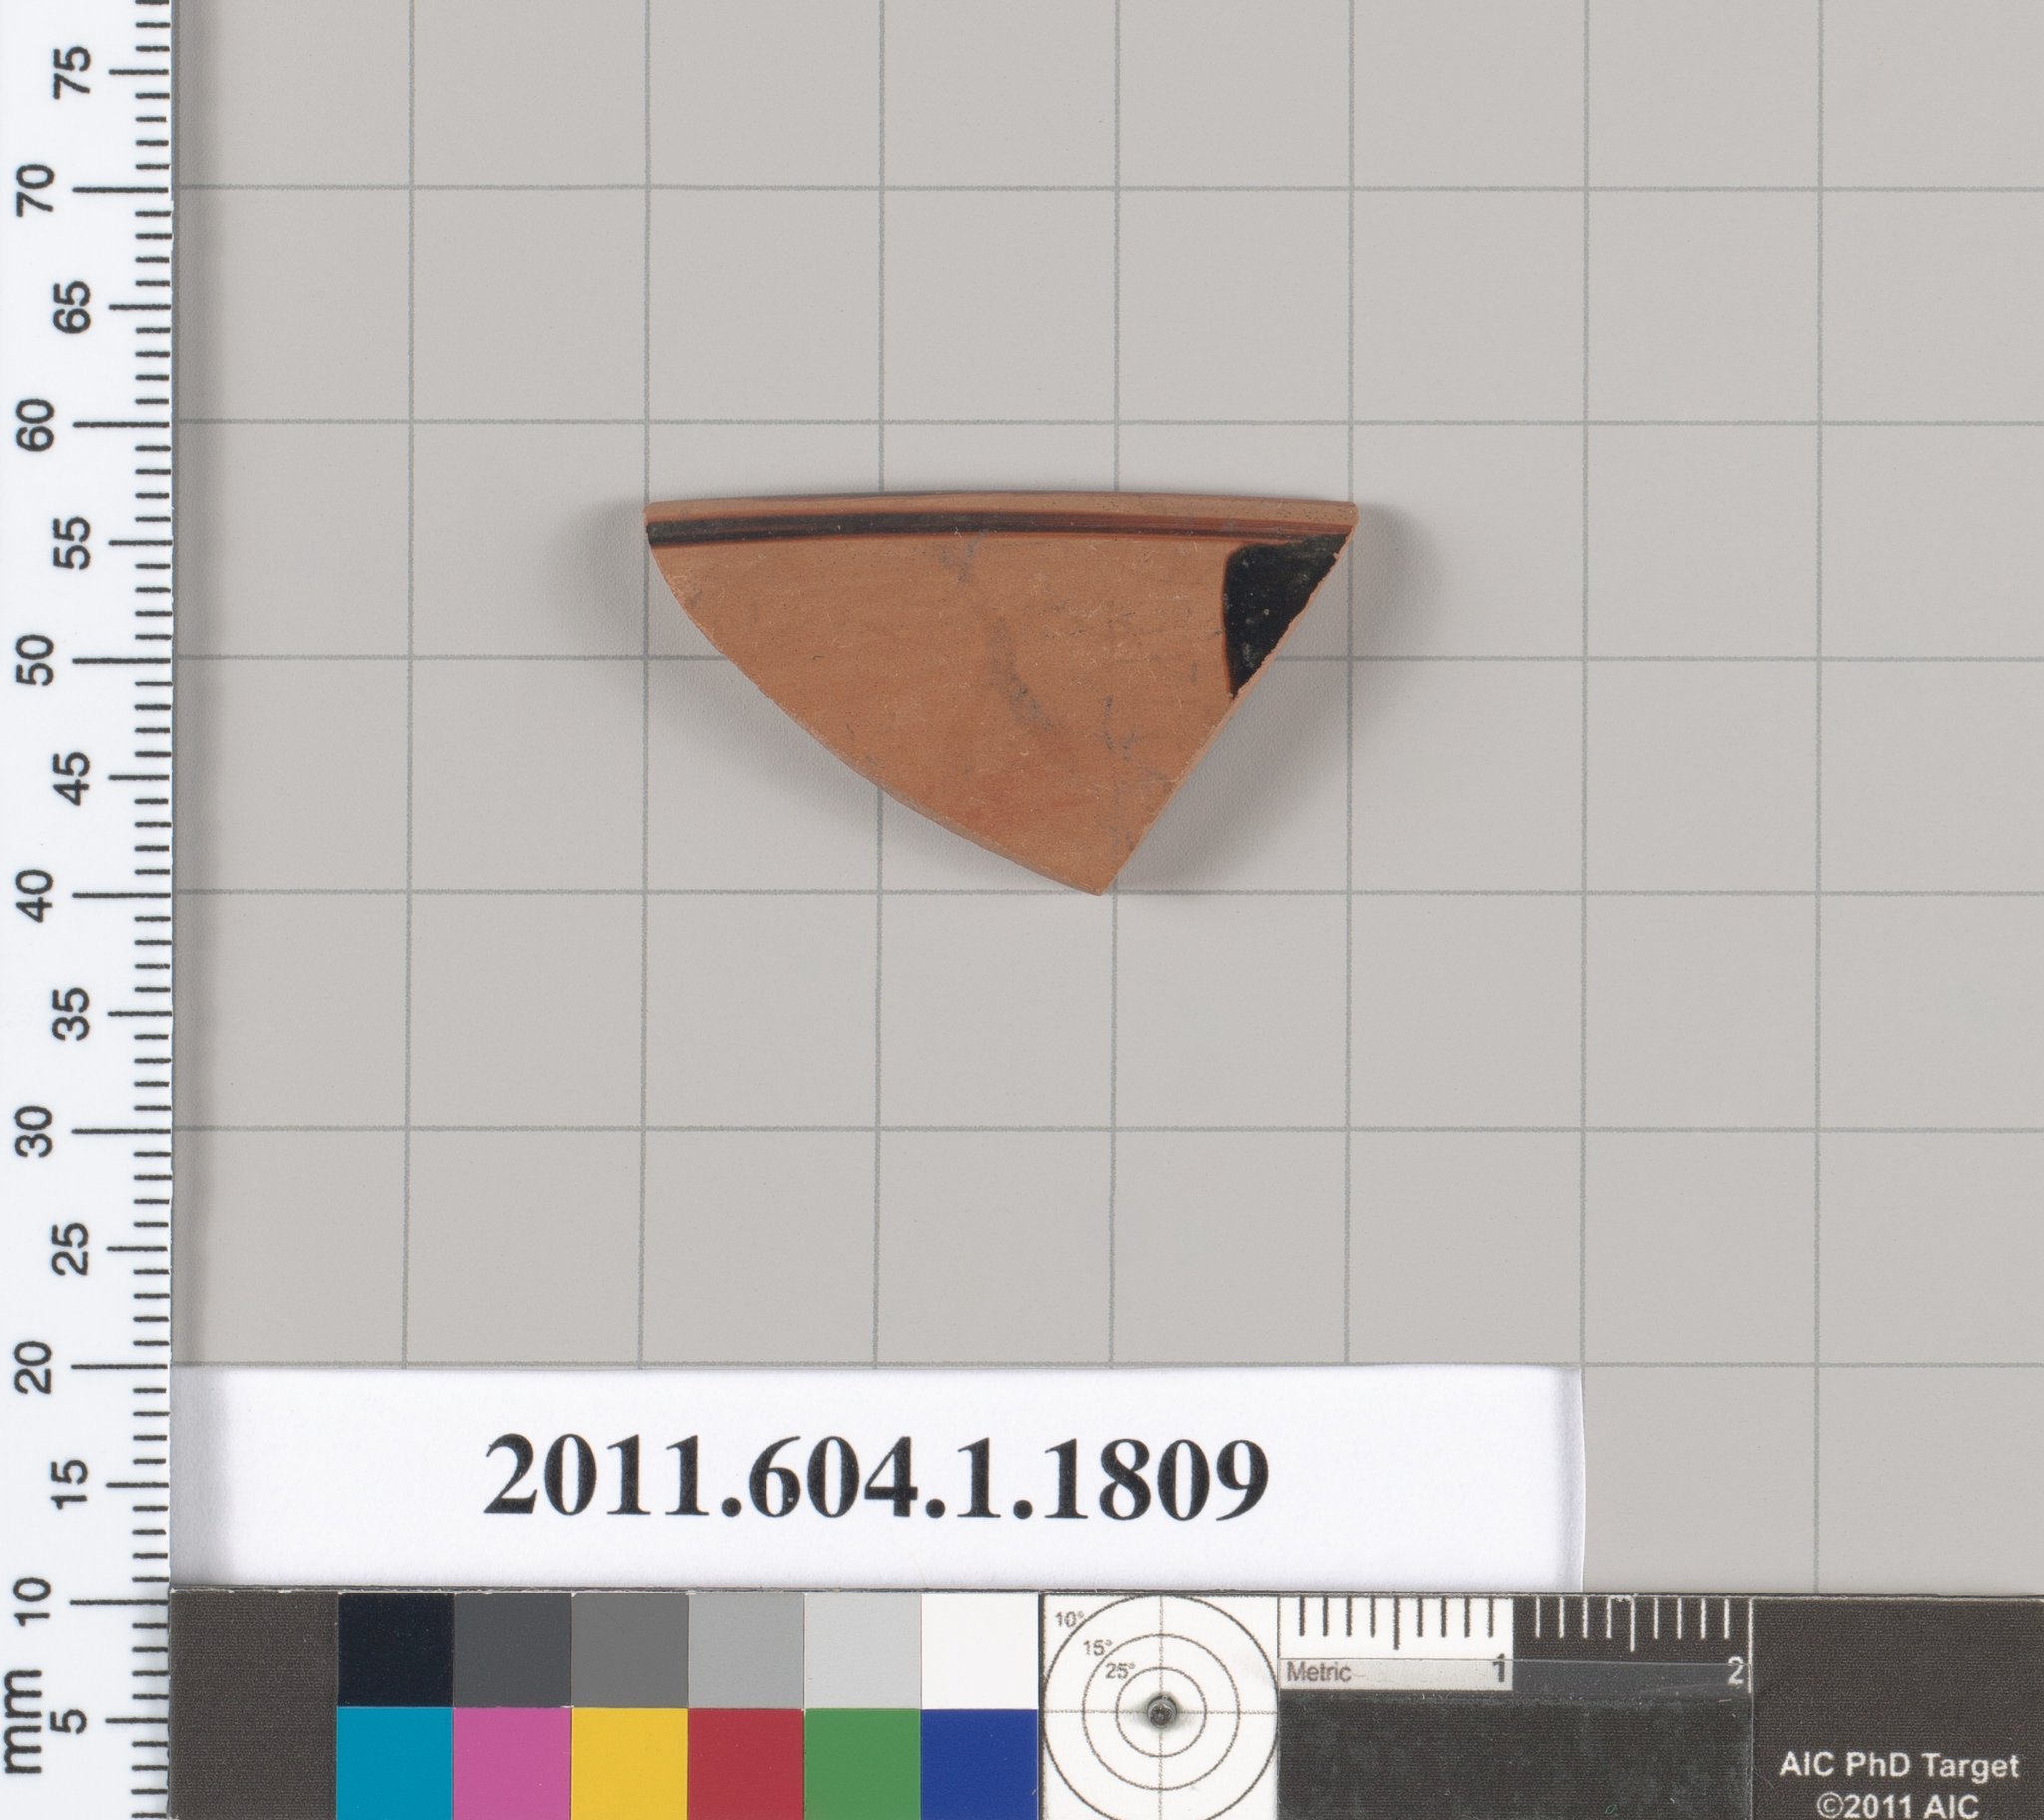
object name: kylix fragment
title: Terracotta rim fragment of a kylix (drinking cup)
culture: greek, attic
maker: makron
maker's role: artist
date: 500-401 BCE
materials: terracotta